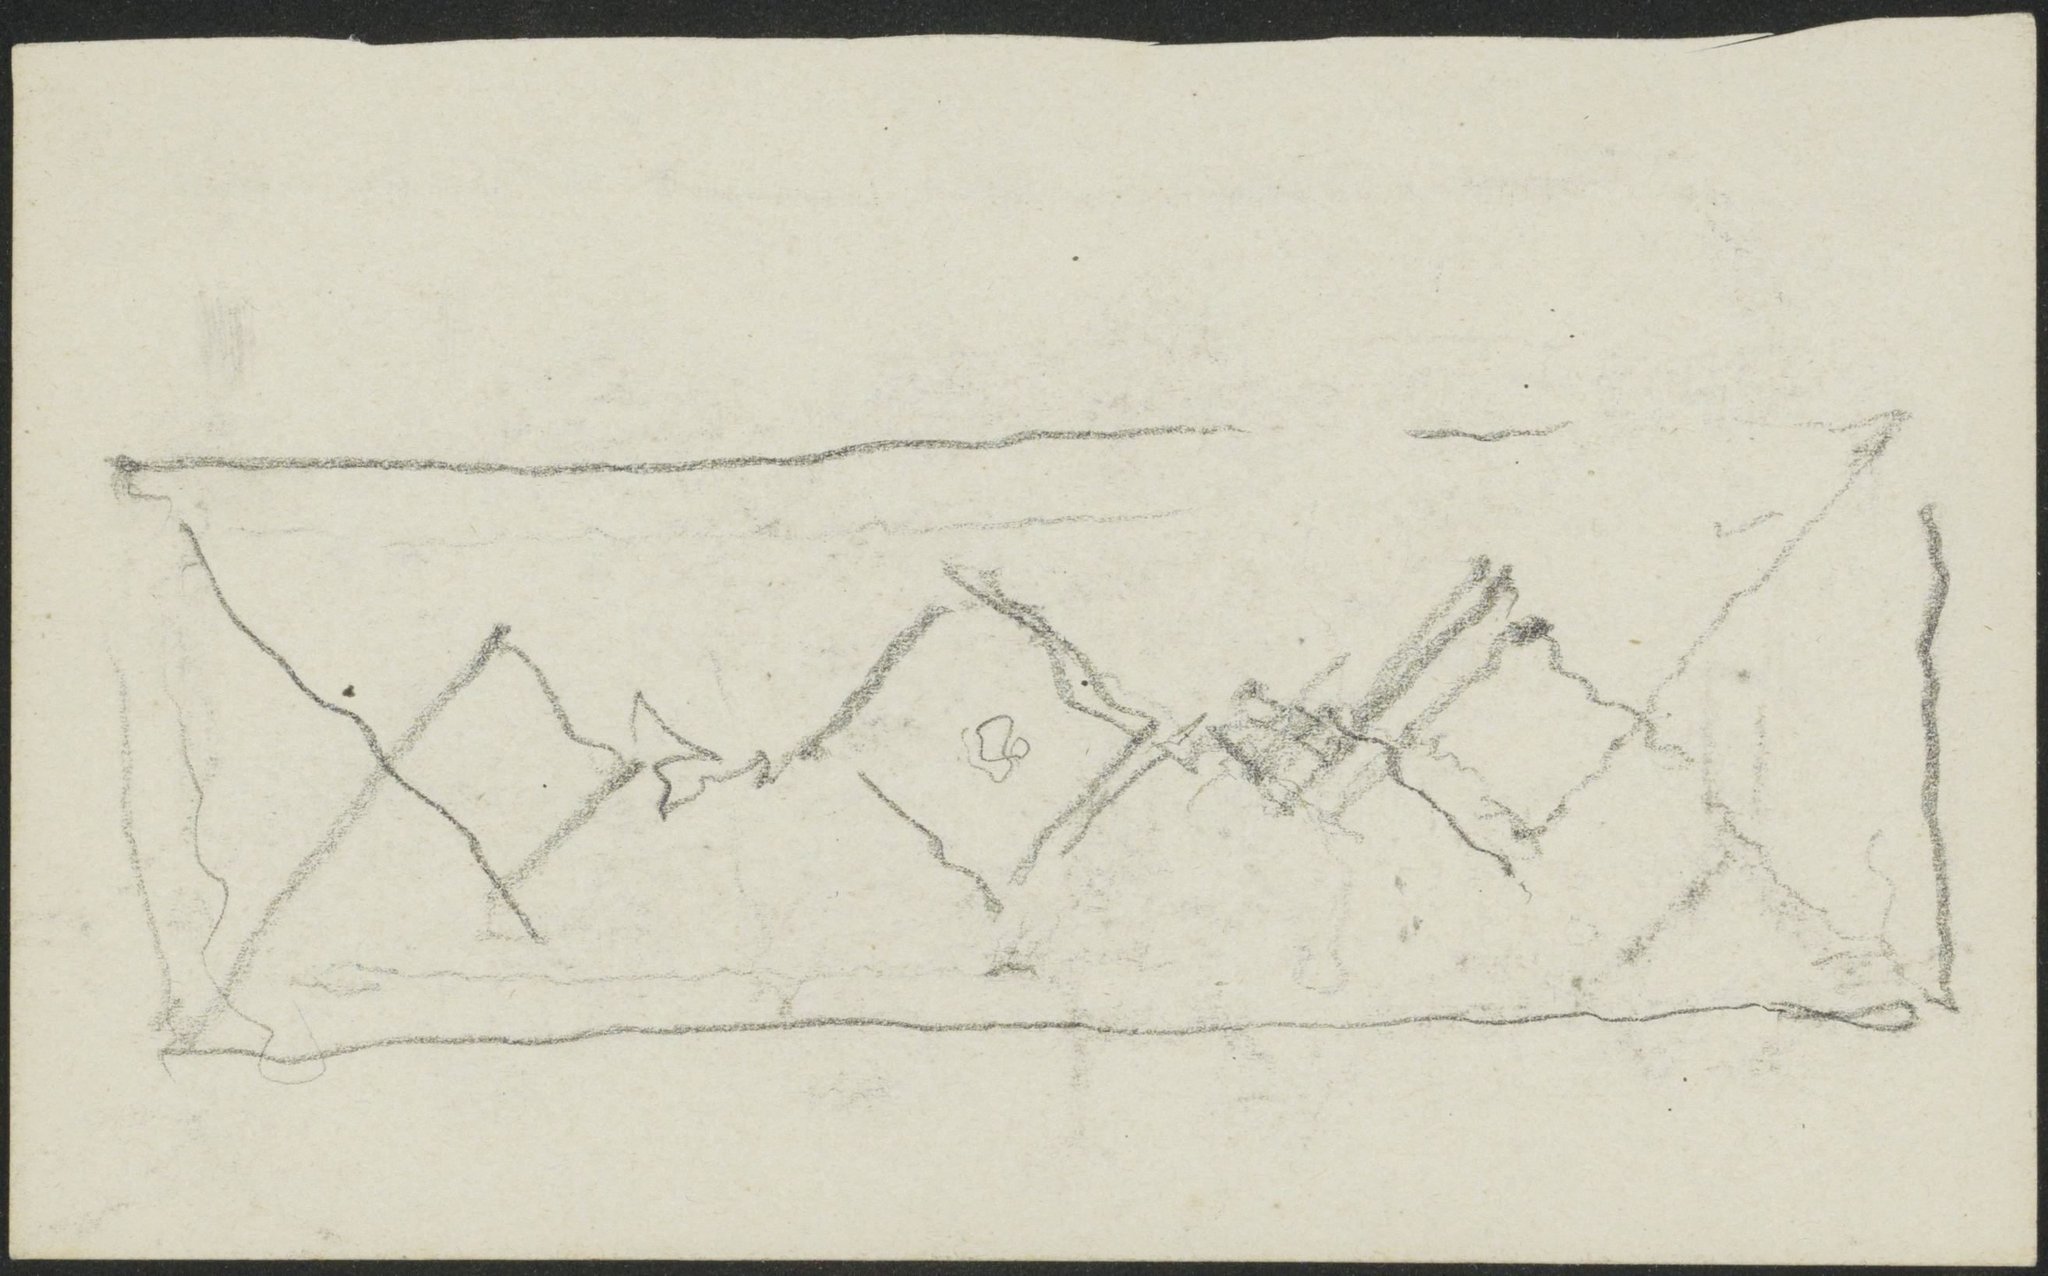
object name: drawing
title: Rechthoek met een ruitpatroon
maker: gerrit willem dijsselhof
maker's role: designer, draughtsman, print maker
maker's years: 1866-1924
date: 1876-1924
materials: chalk, paper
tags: ornaments ~ art